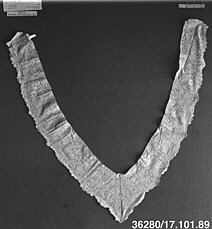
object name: neckpiece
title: Shaped neckpiece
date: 1701-1733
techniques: lace